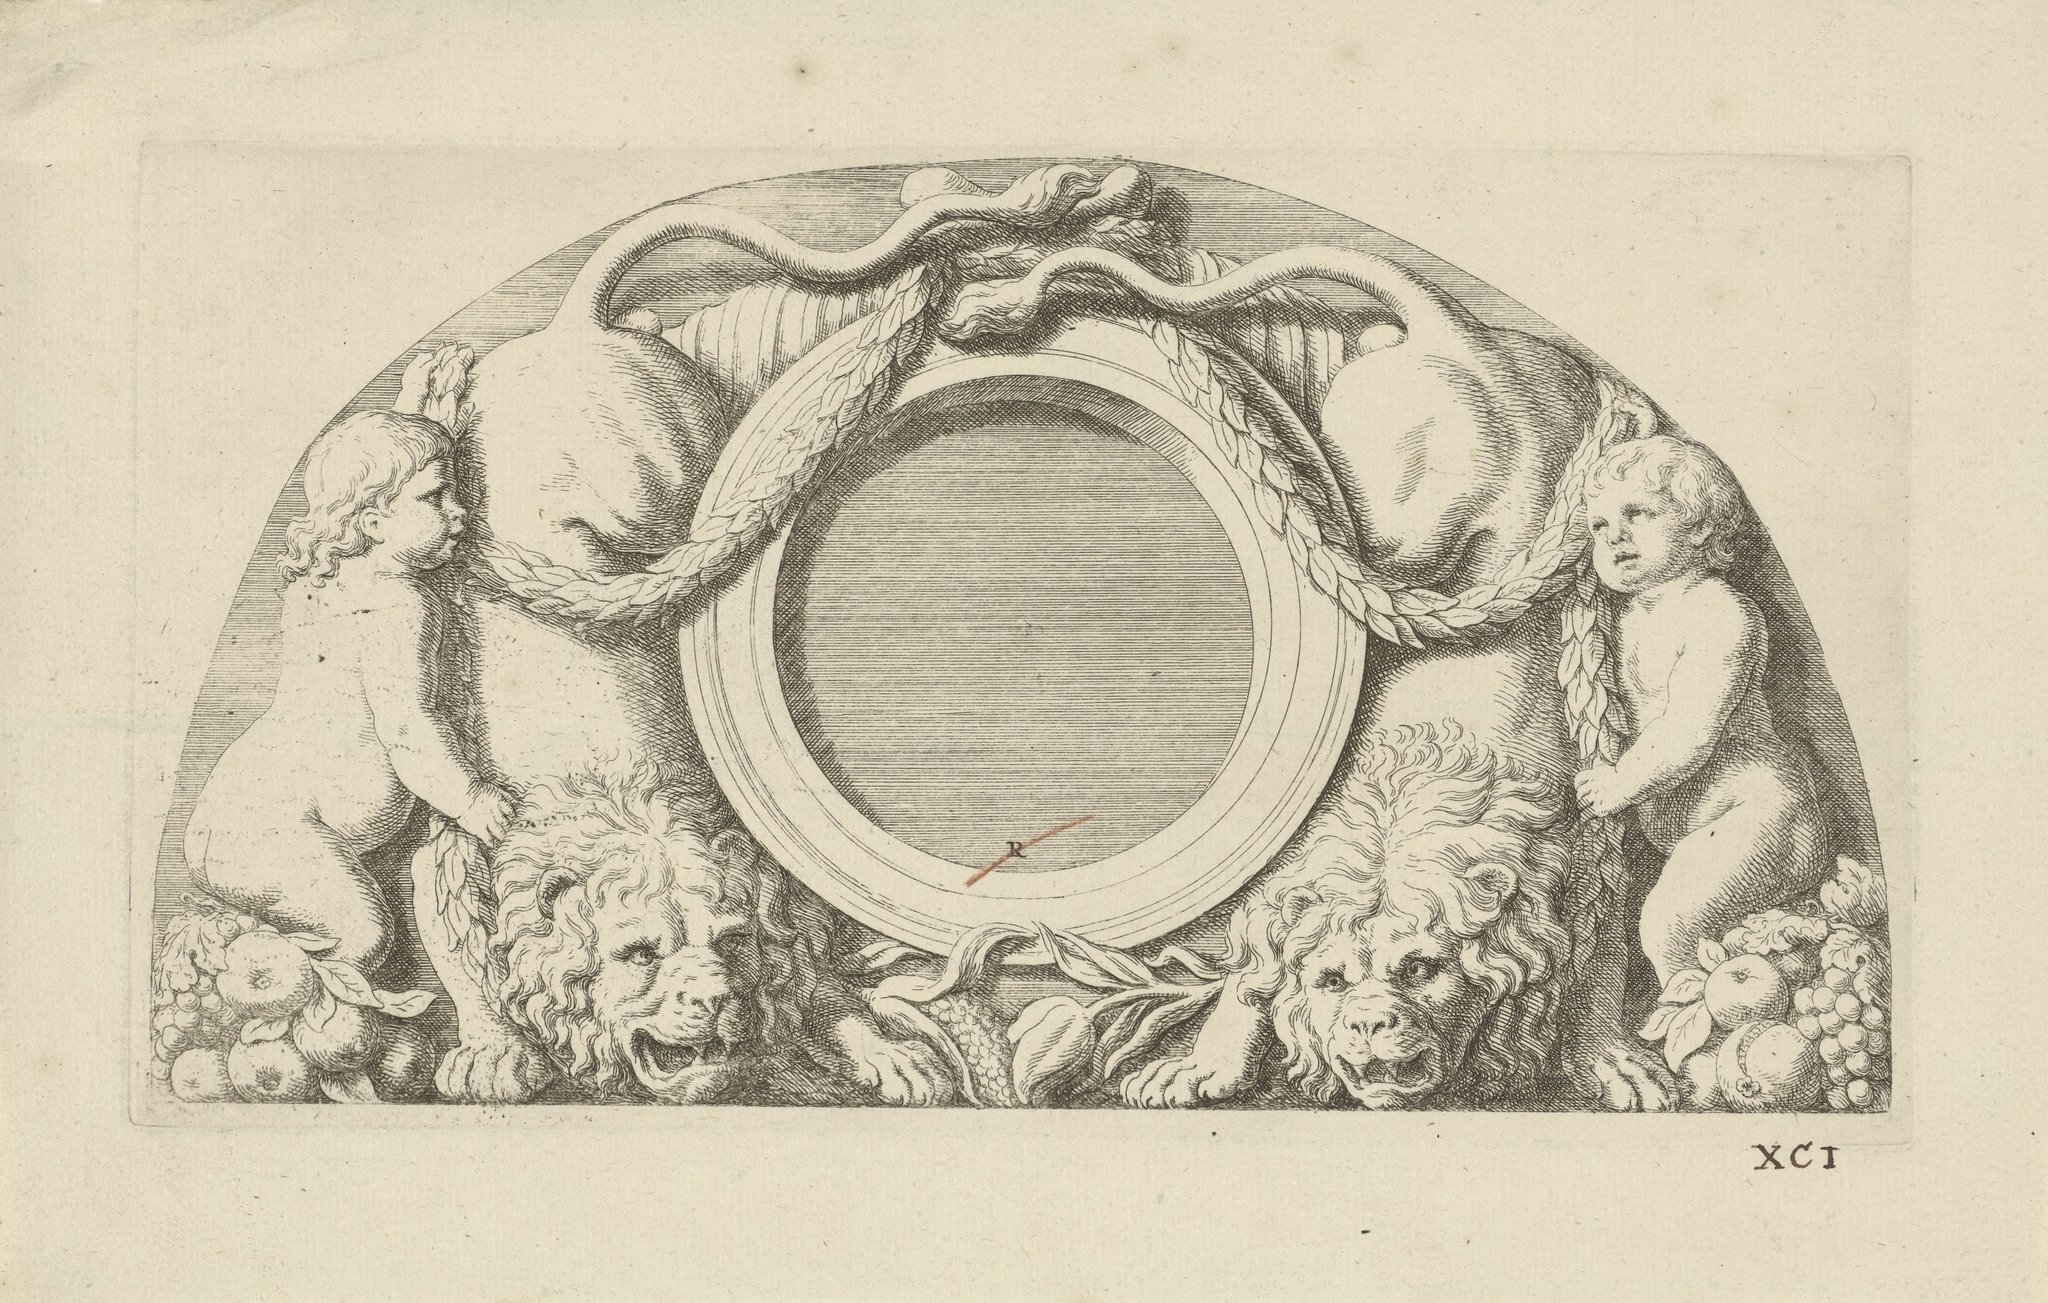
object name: book illustration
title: Lunette met putti, leeuwen en hoornen des overvloeds in de oostelijke galerij van het Stadhuis op de Dam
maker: hubert quellinus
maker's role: print maker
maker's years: 1619-1687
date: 1655-1665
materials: chalk, ink, paper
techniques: engraving, etching, pen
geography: amsterdam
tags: 'cornucopia', horn of plenty, beasts of prey, predatory animals: lion, cupids: 'amores', 'amoretti', 'putti', attributes of cybele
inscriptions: collector's mark: Lugt 2228, inscription: ‘XCI’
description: Huidige staat van prent ook gebruikt in: Prima pars. Praecipuarum effigierum ac ornamentorum, amplissimae Curiae Amstelrodamensis (…) / Het eerste deel. Van de voornaemste Statuen ende Ciraten, vant konstijck Stadhuys van Amstelredam, tmeeste in marmer gemaeckt, door Artus Quellinus, Beelthouwer der voorseyde Stadt / La Premier Partie. De plusieurs Figures et ornements, de la Maison de Ville d'Amsterdam (…). Amsterdam: Artus Quellinus (I), 1655. En in: Prima pars. Praecipuarum effigierum ac ornamentorum, amplissimae Curiae Amstelrodamensis (…) / Het eerste deel. Van de voornaemste Statuen ende Ciraten, vant konstijck Stadhuys van Amstelredam, tmeeste in marmer gemaeckt, door Artus Quellinus, Beelthouwer der voorseyde Stadt / La Premier Partie. De plusieurs Figures et ornements, de la Maison de Ville d'Amsterdam (…). Amsterdam: Frederik de Wit, 1665. Latere staat van prent ook gebruikt in: Architecture peinture et sculpture de la Maison de Ville d'Amsterdam, representee en CIX. figures en taille-douce (…). Amsterdam: David Mortier, 1719. En in: Architecture peinture et sculpture de la Maison de Ville d'Amsterdam, representee en CIX. figures en taille-douce (…). Amsterdam: Gerard Valck, 1719. En in: Bouw schilder en beeldhouwkonst, van het Stadhuis te Amsteldam, vertoont in CIX figuuren (…). Amsterdam: Covens & Mortier & Covens Jr., s.a. (1774-1783).